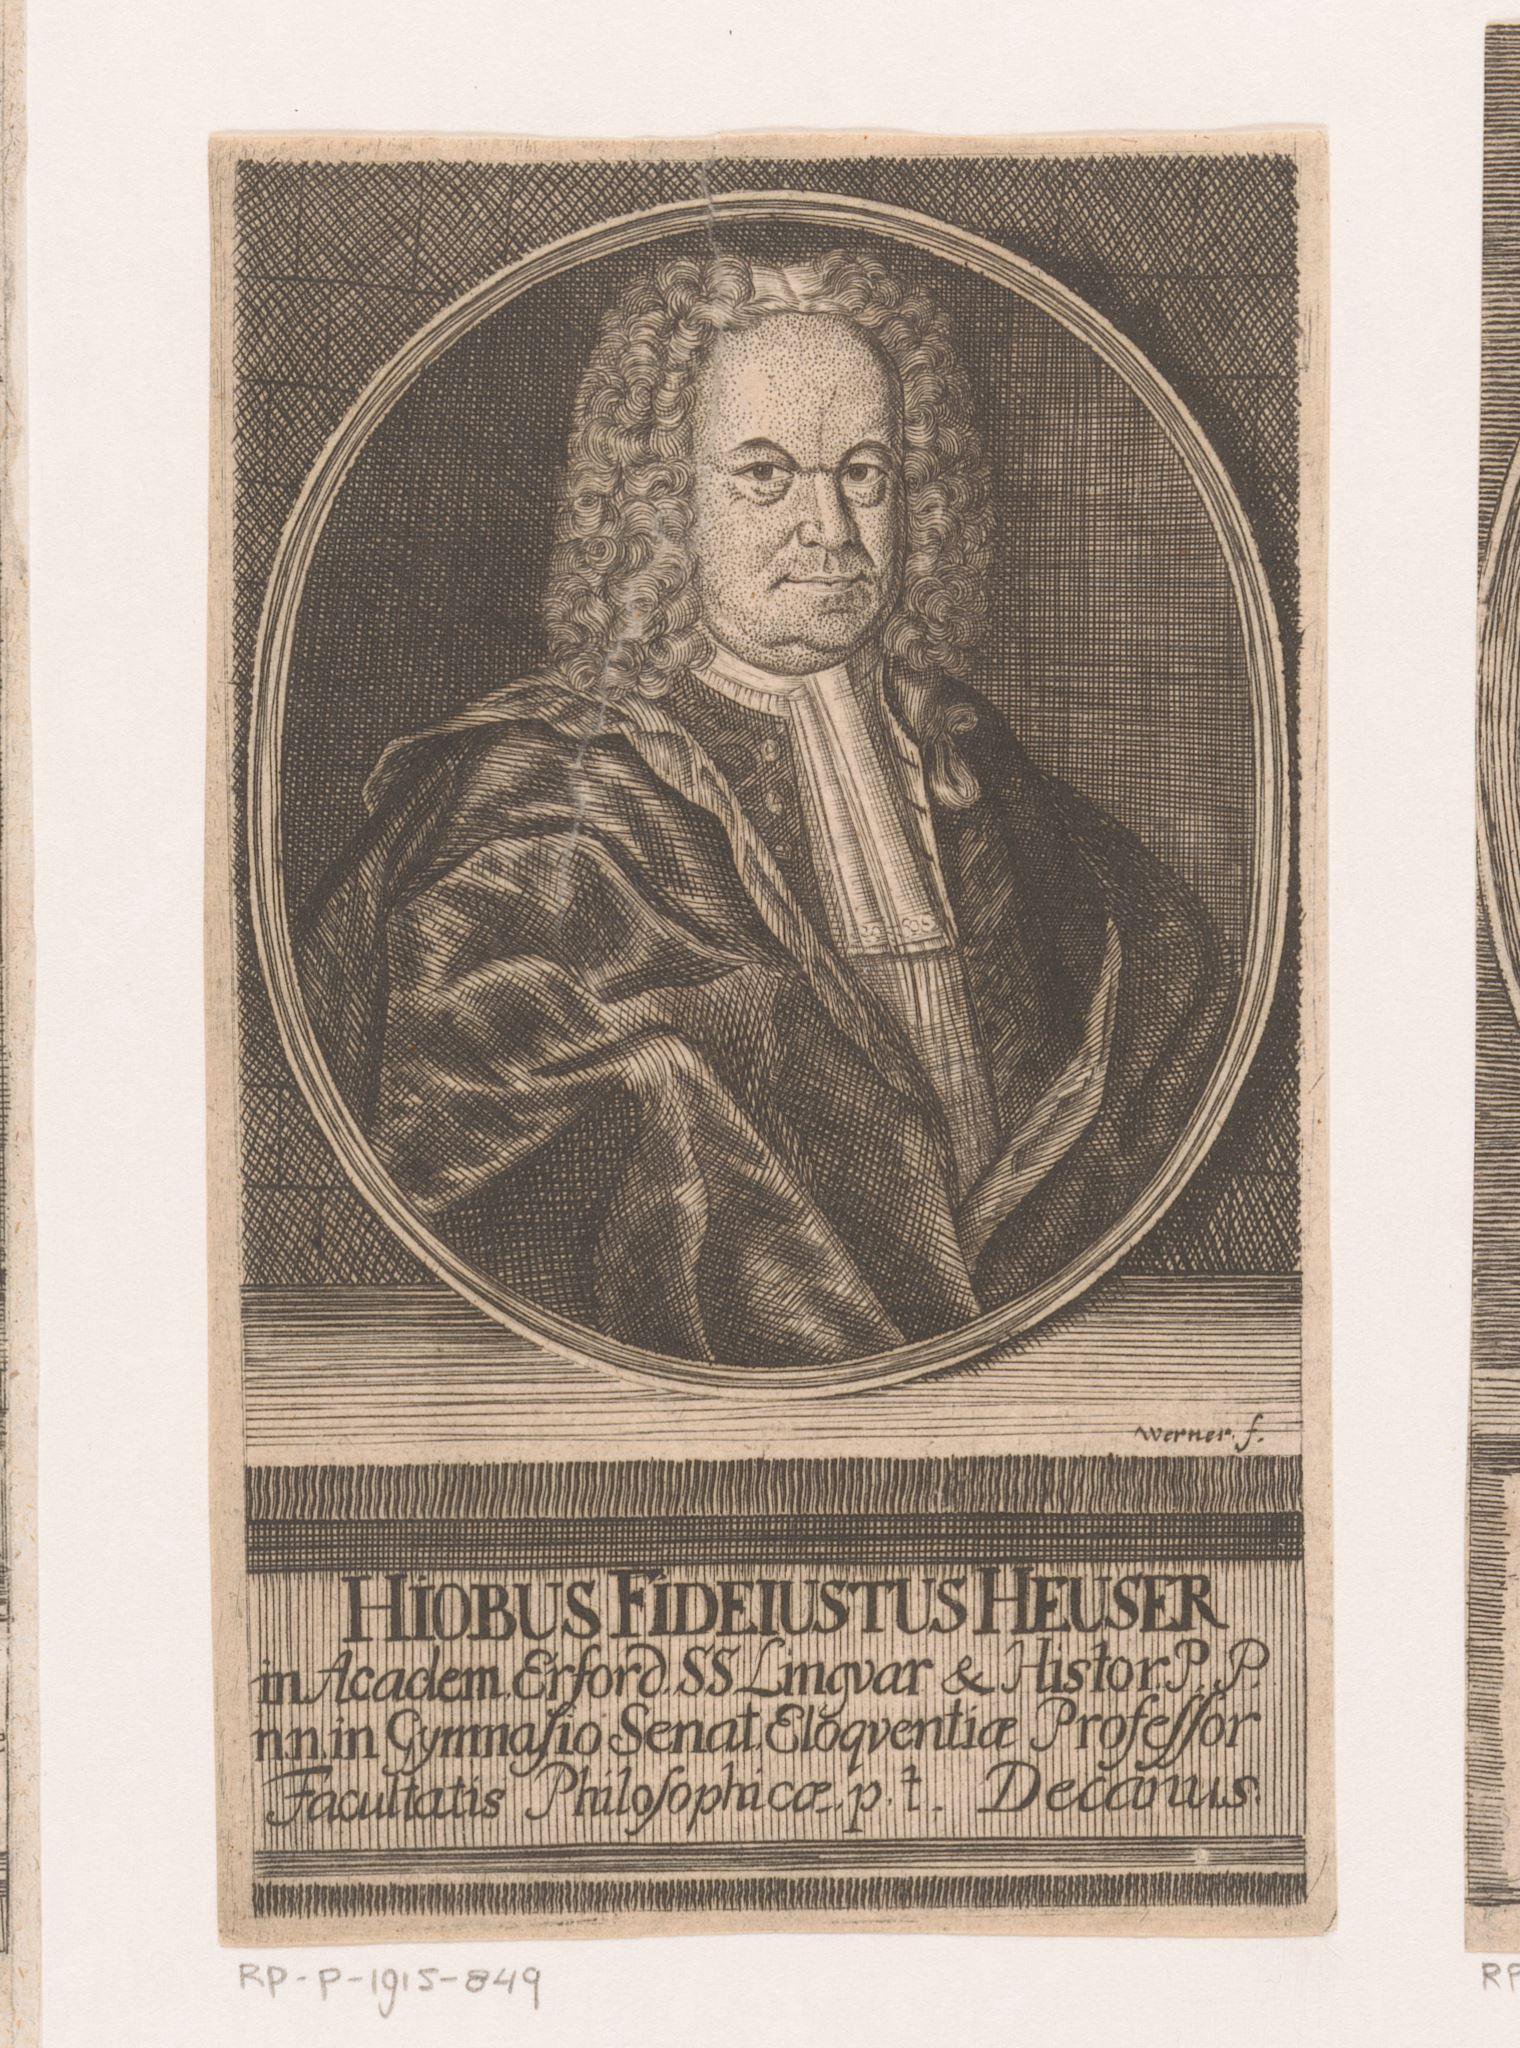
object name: print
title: Portret van Job Fideiustus Heuser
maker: georg heinrich werner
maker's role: print maker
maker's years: 1723-1789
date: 1733-1789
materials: paper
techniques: engraving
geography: germany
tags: historical persons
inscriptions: collector's mark: Lugt 2228